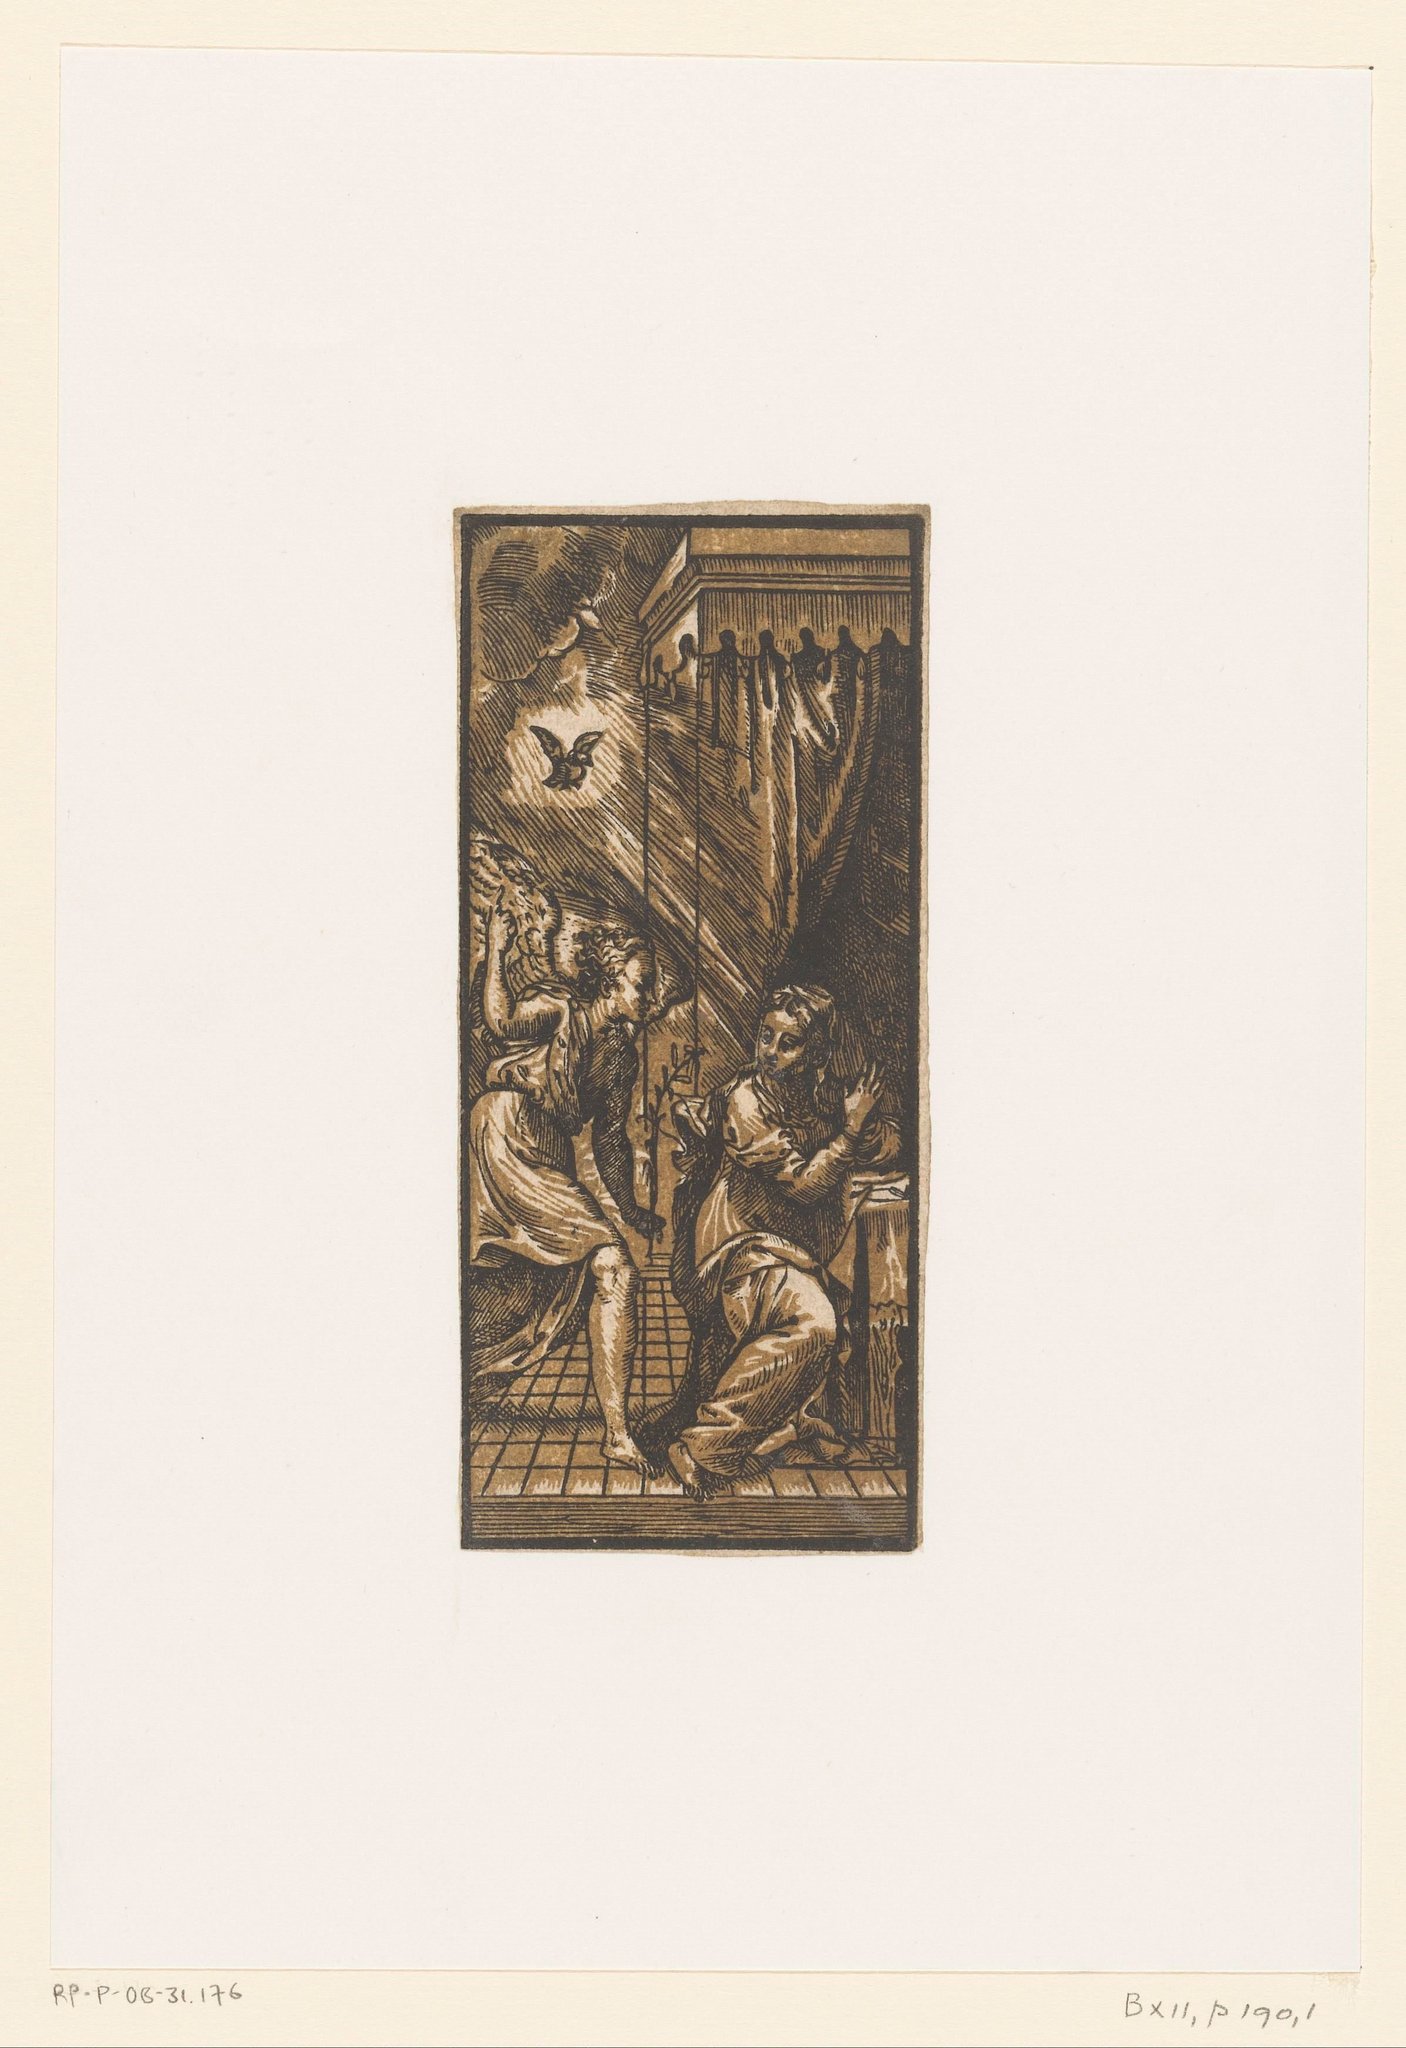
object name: print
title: Annunciatie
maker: anton maria i zanetti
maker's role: draughtsman, painter, print maker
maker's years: 1680-1757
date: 1690-1757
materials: paper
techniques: woodcut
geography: italy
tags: the annunciation: mary kneeling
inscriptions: collector's mark: Lugt 240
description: De engel Gabriël kondigt aan Maria aan dat ze zwanger zal worden. Maria zit bij een tafel en achter haar staat een bed. De Heilige Geest daalt als een duif neer.